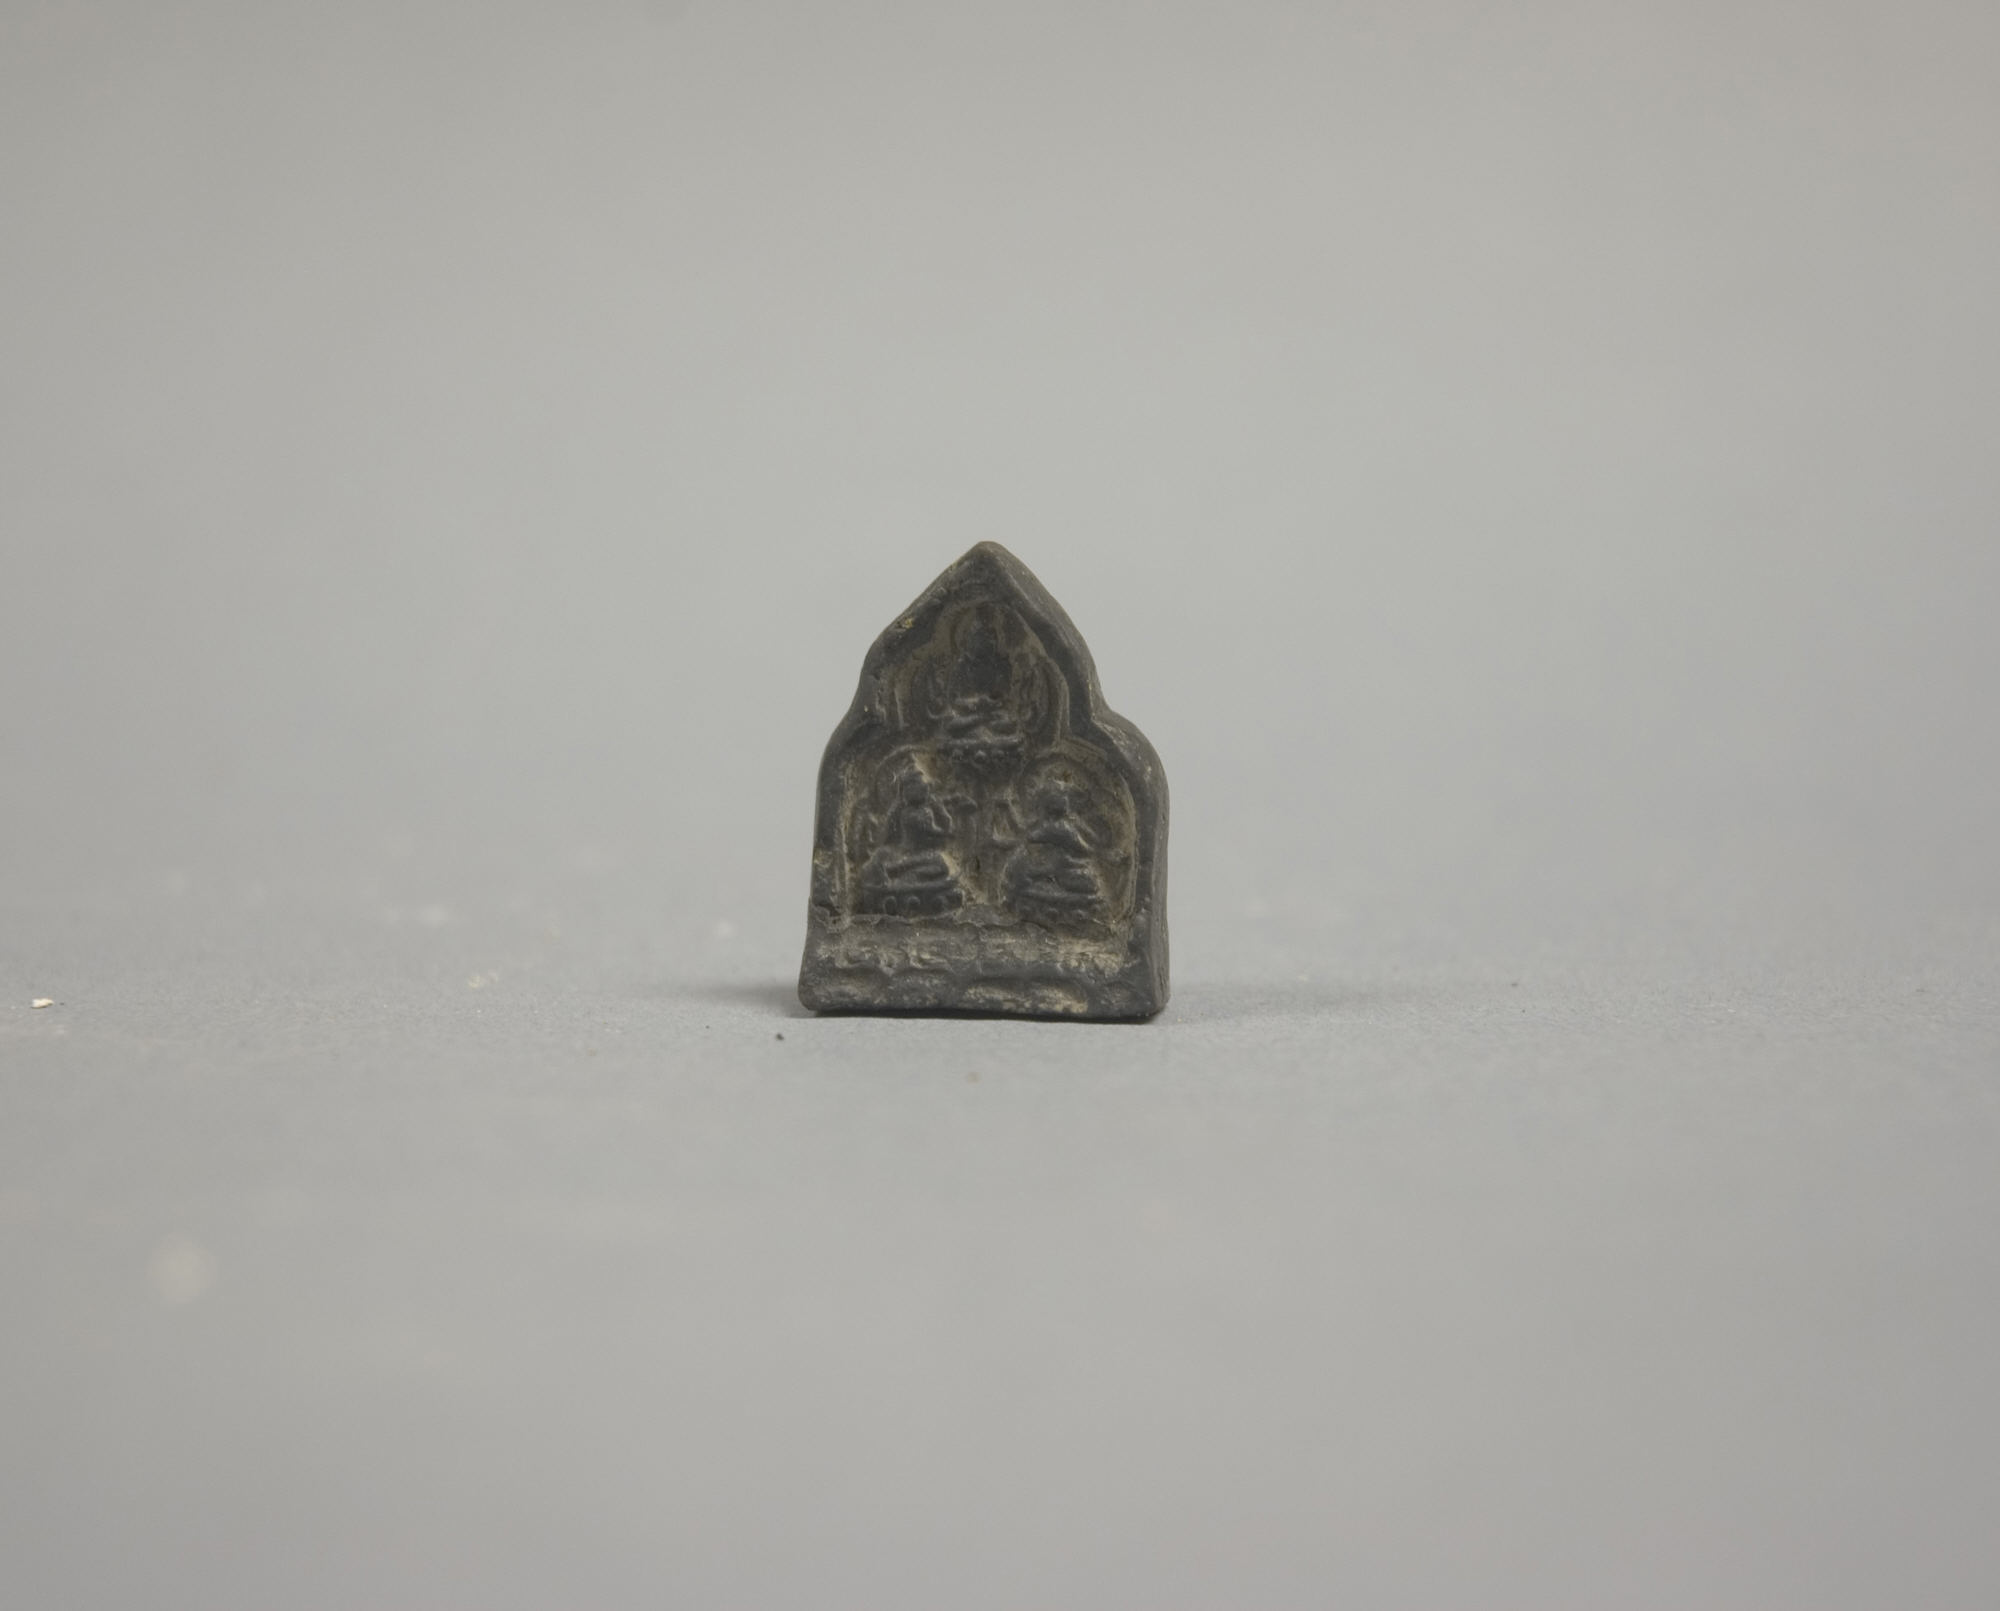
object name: votive plaque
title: Votive Plaque with Amitāyus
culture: tibetan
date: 701-800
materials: clay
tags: buddhism,buddha